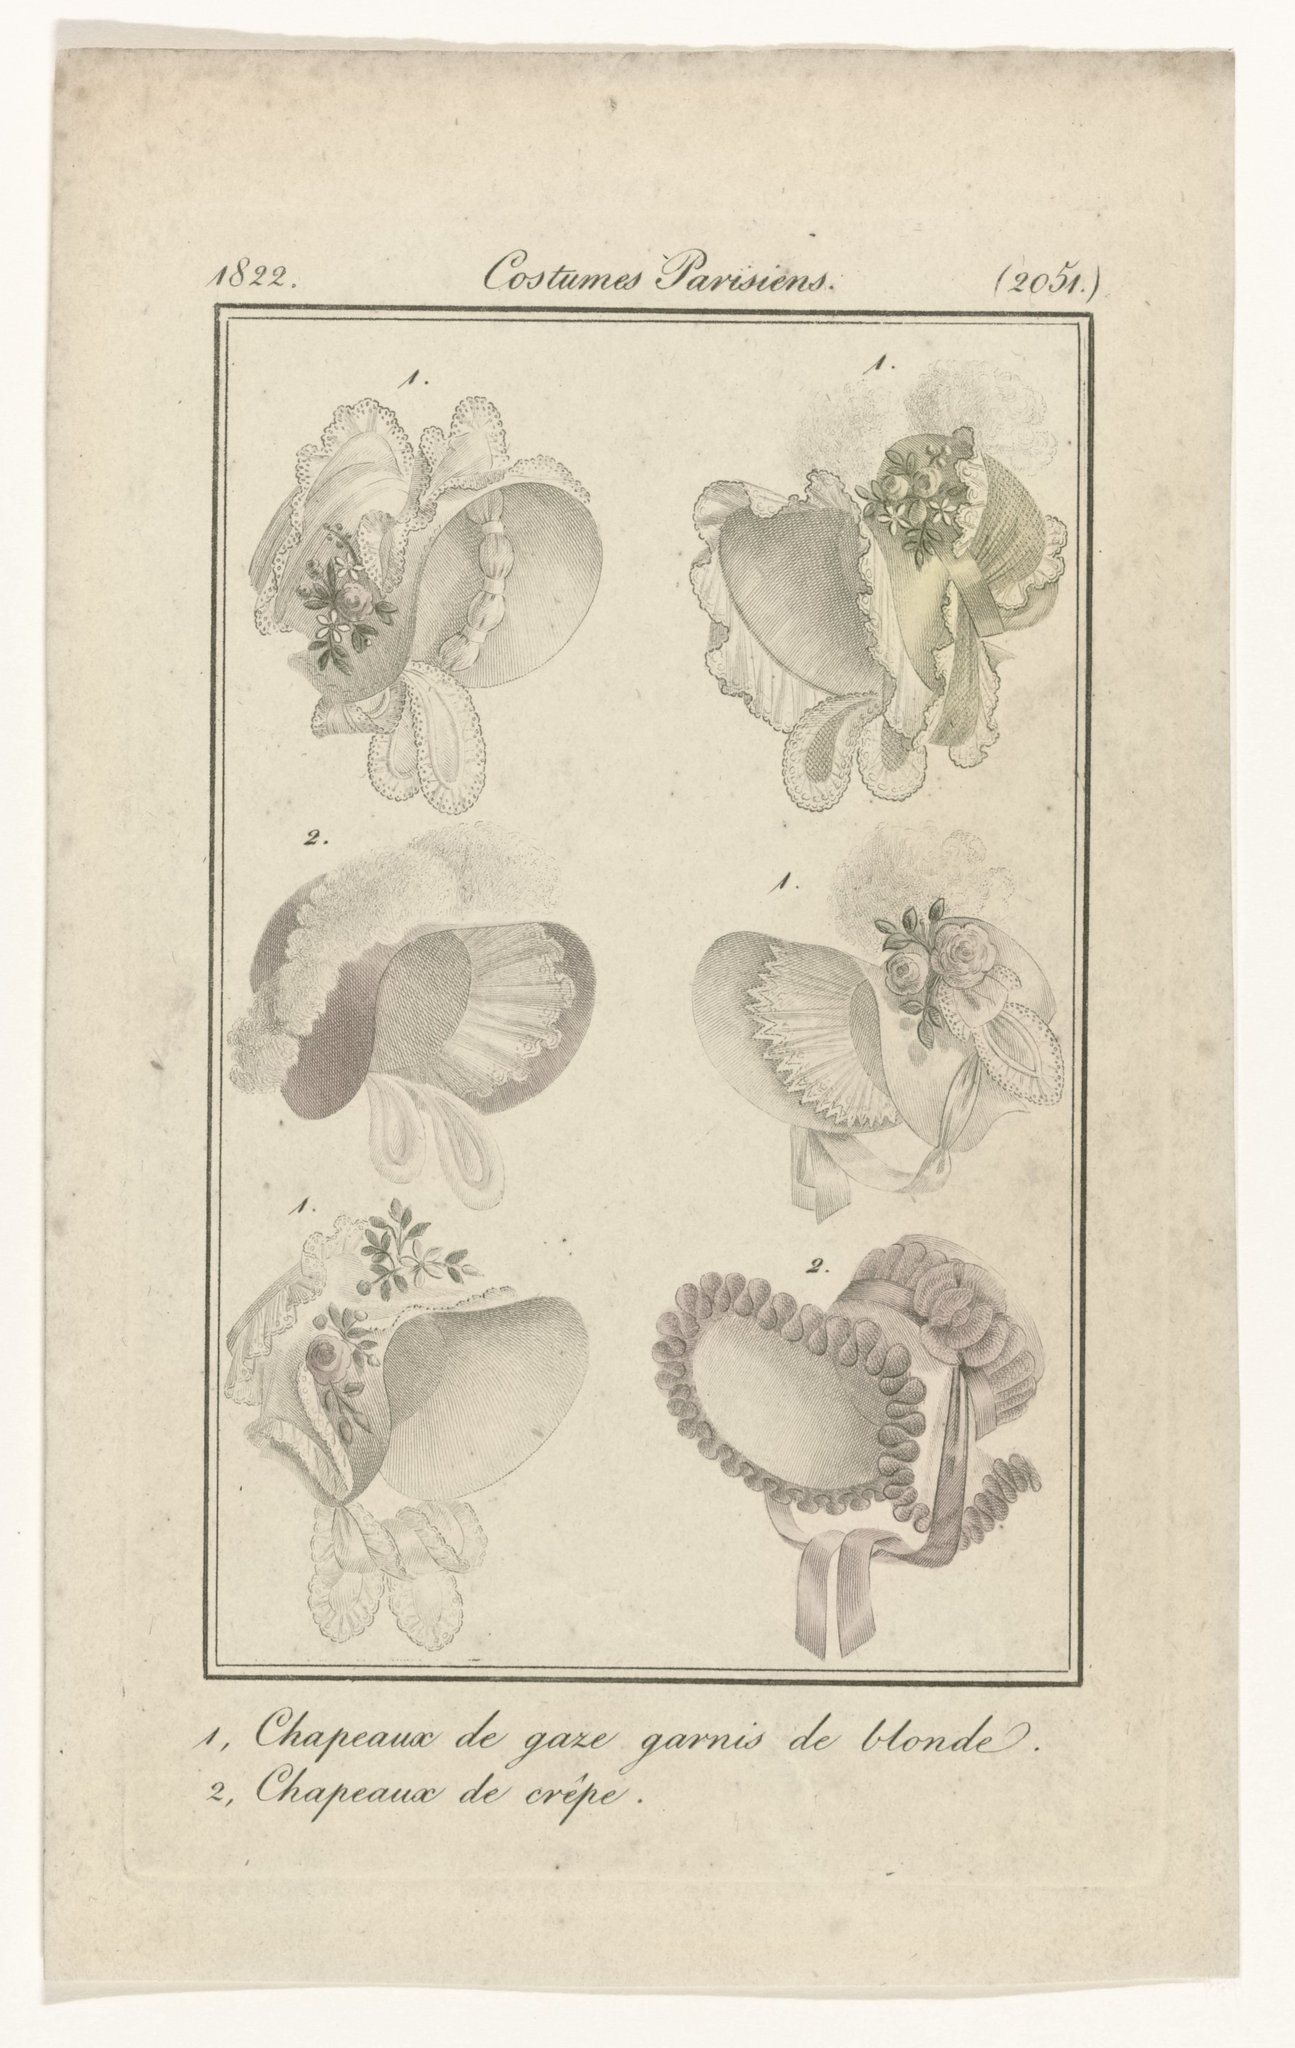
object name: fashion print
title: Journal des Dames et des Modes, Costumes Parisiens, 1822, (2051): 1, Chapeaux de gaz (...)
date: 1822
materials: paper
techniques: engraving, hand coloring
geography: paris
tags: flowers, lace (+ women's clothes), fashion plates, head-gear: hat (+ women's clothes)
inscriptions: title: ‘Costumes Parisiens.’, caption: ‘1, Chapeaux de gaze garnis de blonde. 2, Chapeaux de crêpe.’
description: De prent maakt deel uit van het modetijdschrift Journal des Dames et des Modes, uitgegeven door Pierre de la Mésangère, Parijs, 1797-1839.